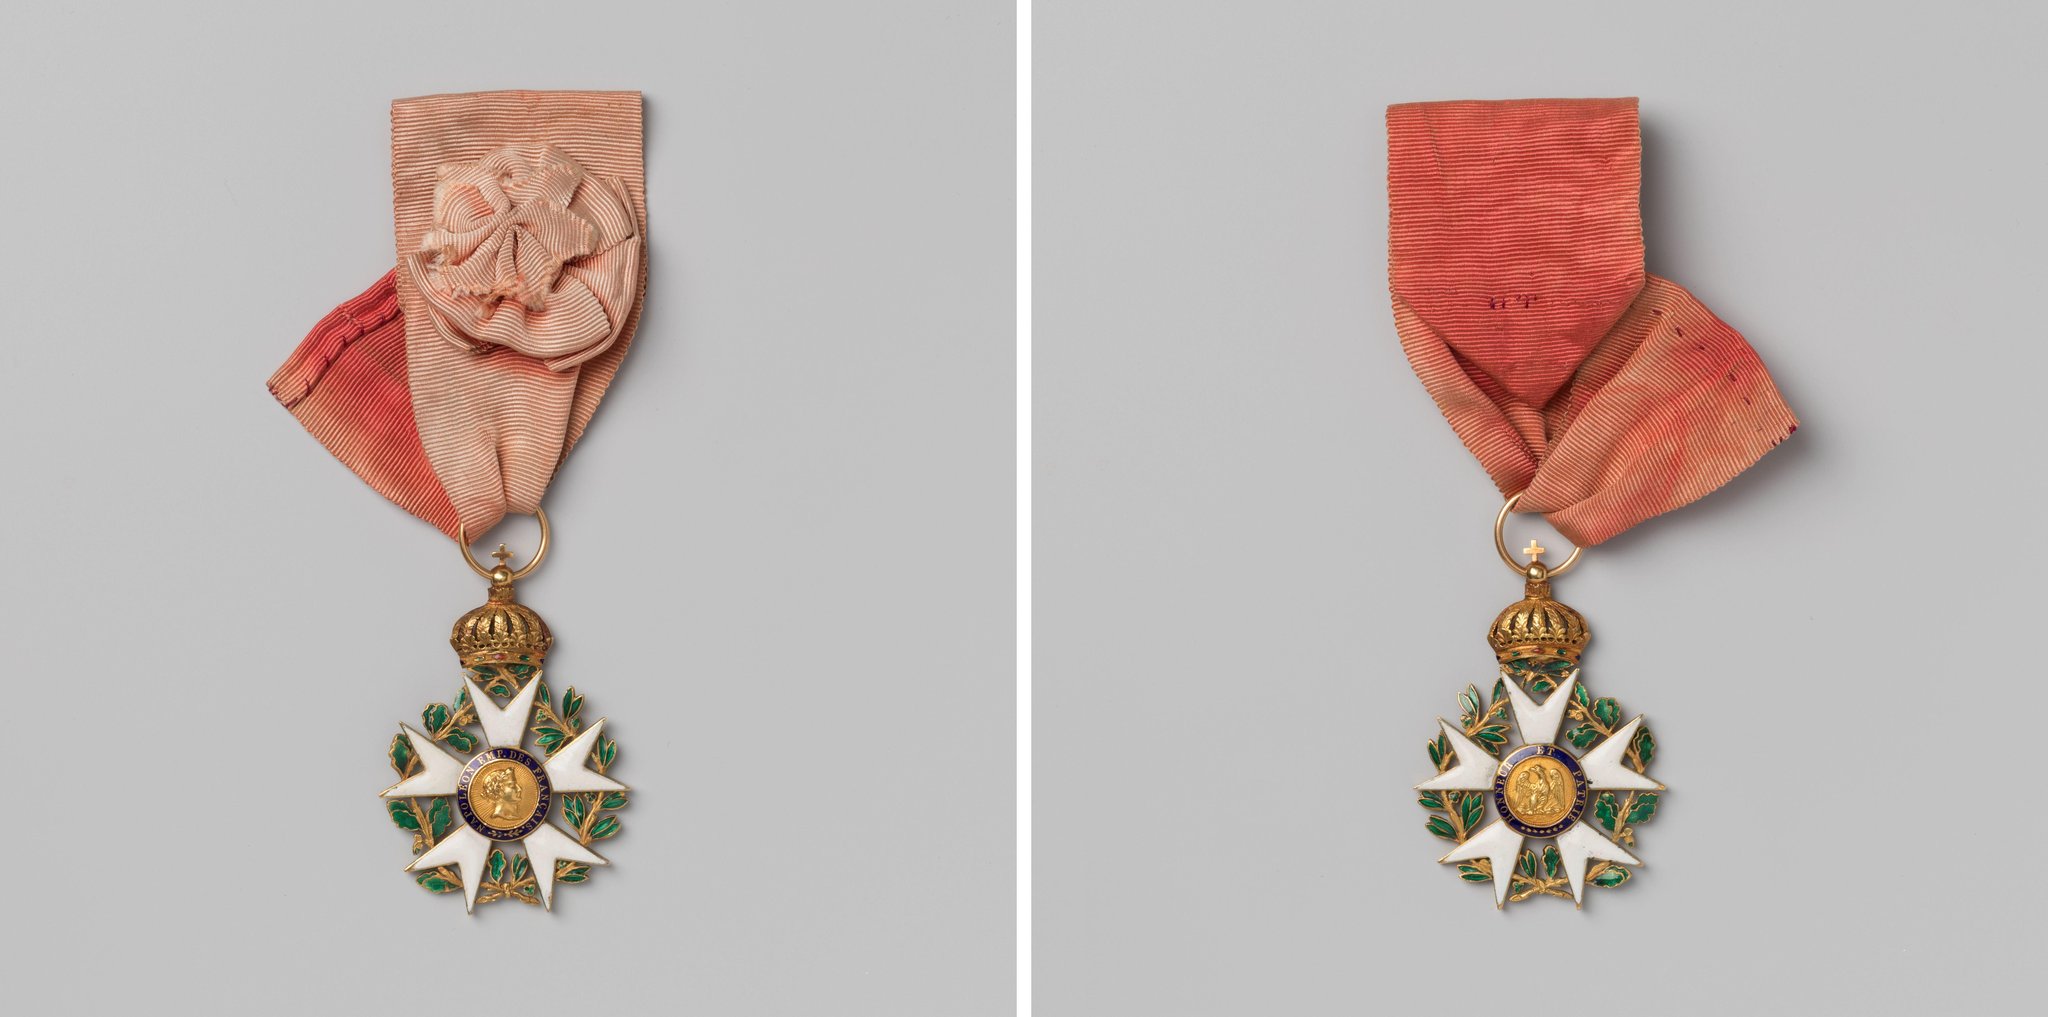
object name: ordeteken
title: Officierskruis van het Legioen van Eer van I.J.A. Gogel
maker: Anonymous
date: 1808-1811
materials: gold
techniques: casting, forging, sewing, striking, weave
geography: france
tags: napoleon i (emperor of the french)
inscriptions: edge inscription: ‘HONNEUR ET PATRIE’, edge inscription: ‘NAPOLEON EMP. DES FRANCAIS’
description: Decorations and medals, 1806-1813. King Louis Napoleon instituted two national orders: the Order of Merit, with the motto 'do well and do not look back', and the Order of the Union, with the motto 'luctor et emergo'. A year later the two orders were merged to form the Royal Order of Holland, renamed the Royal Order of the Union after 1808. Instead of the king's head, the medal showed a bundle of arrows. When the Netherlands was annexed by France in 1810, Emperor Napoleon introduced the Order of Reunion to replace the Order of the Union. These decorations were originally awarded to I.J.A. Gogel, who served for many years as minister of finance.